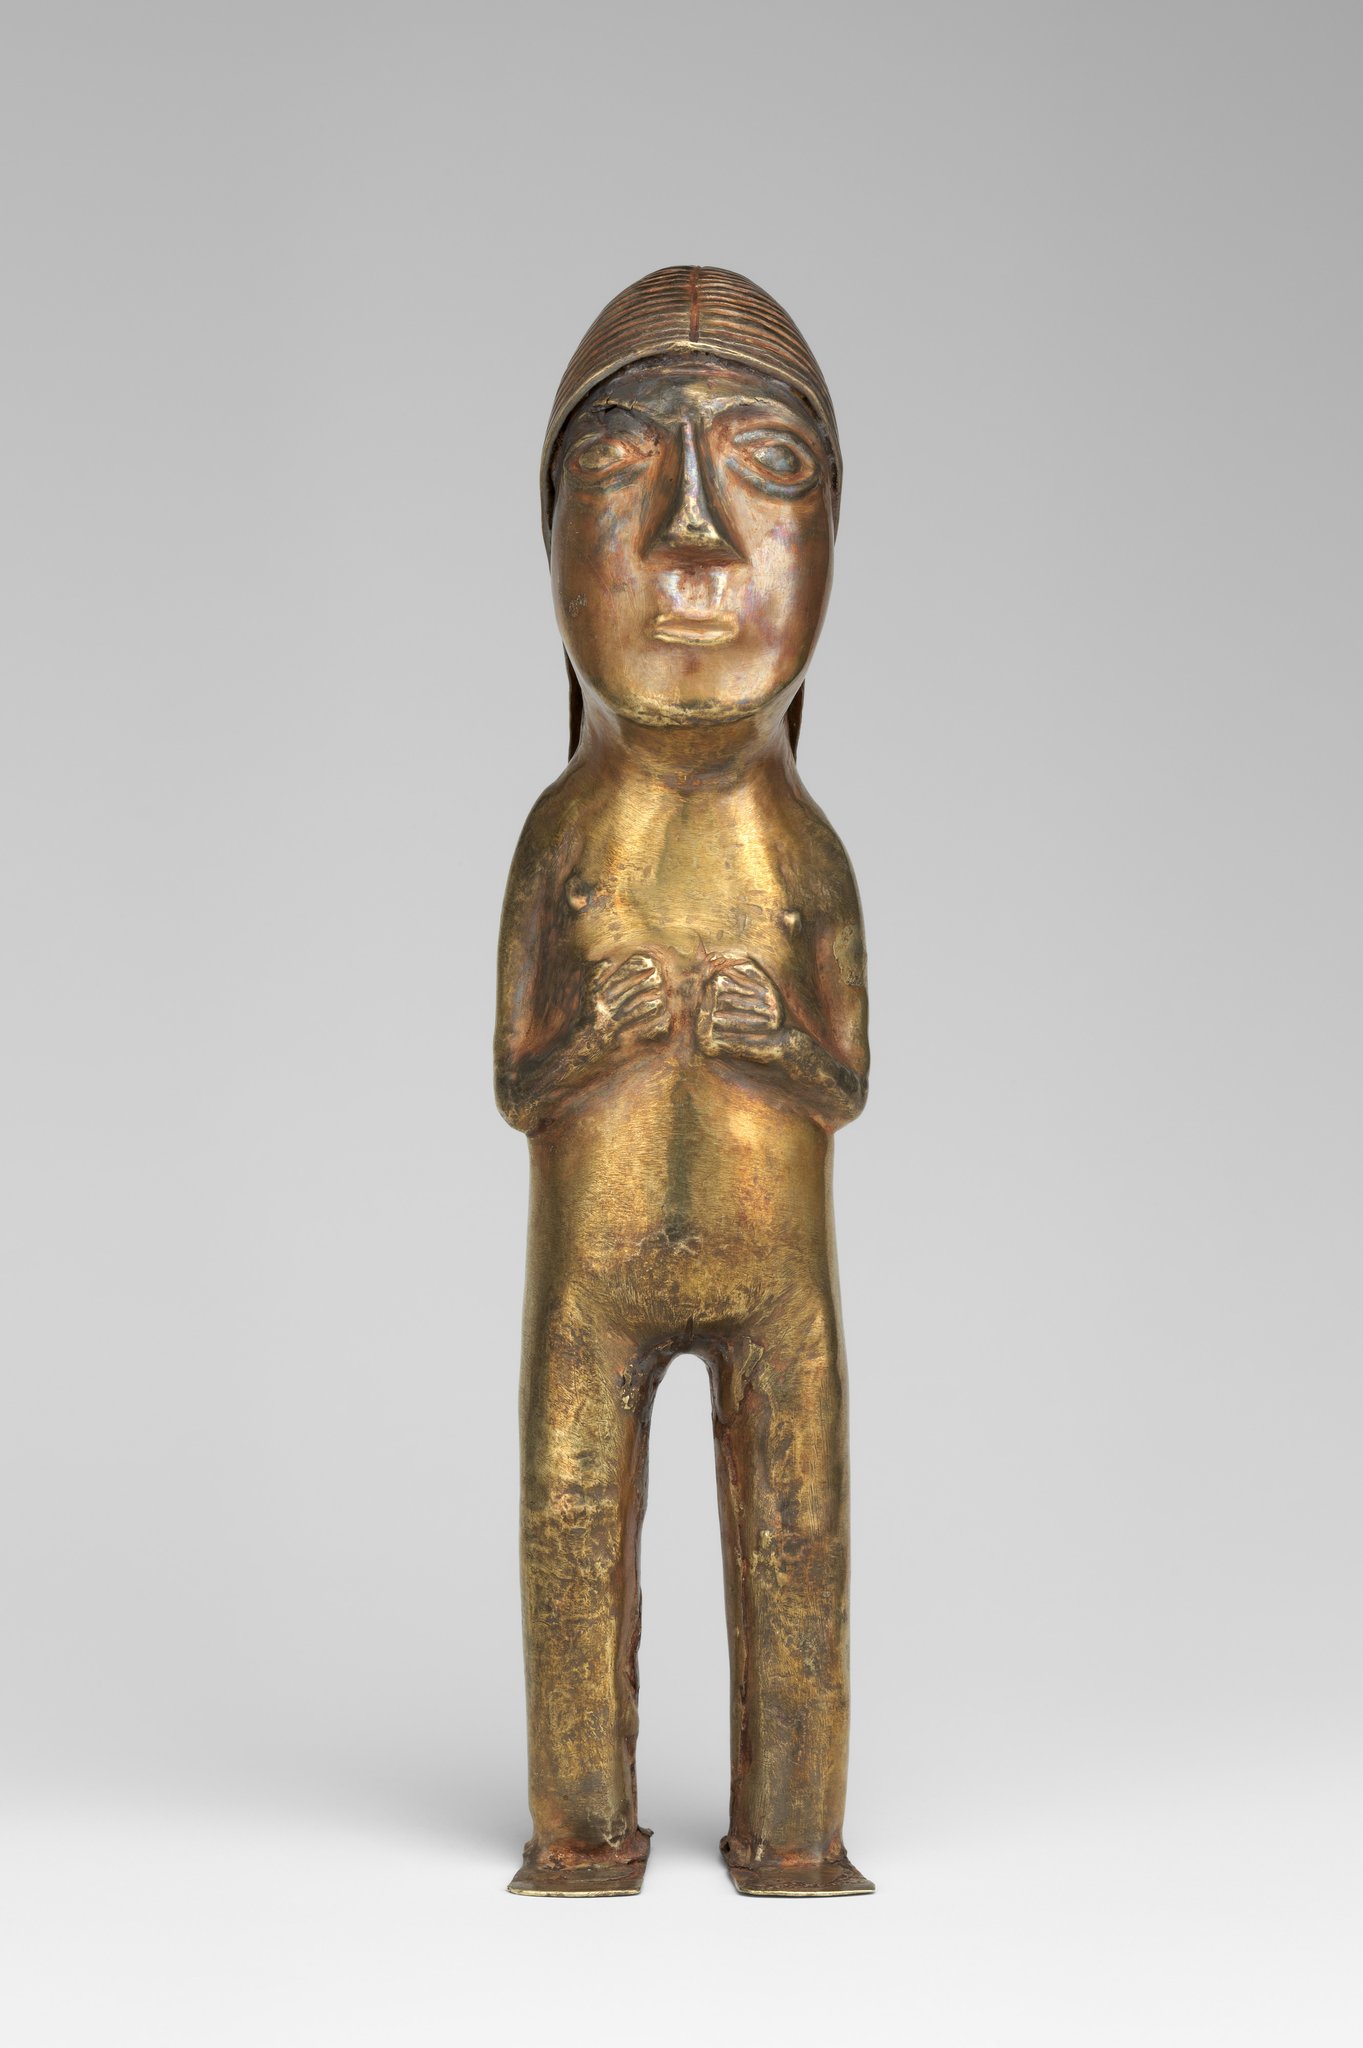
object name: figure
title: Female figurine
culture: inca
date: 1400-1533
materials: alloy, gold, silver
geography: ecuador, peru, bolivia, chile, or argentina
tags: women